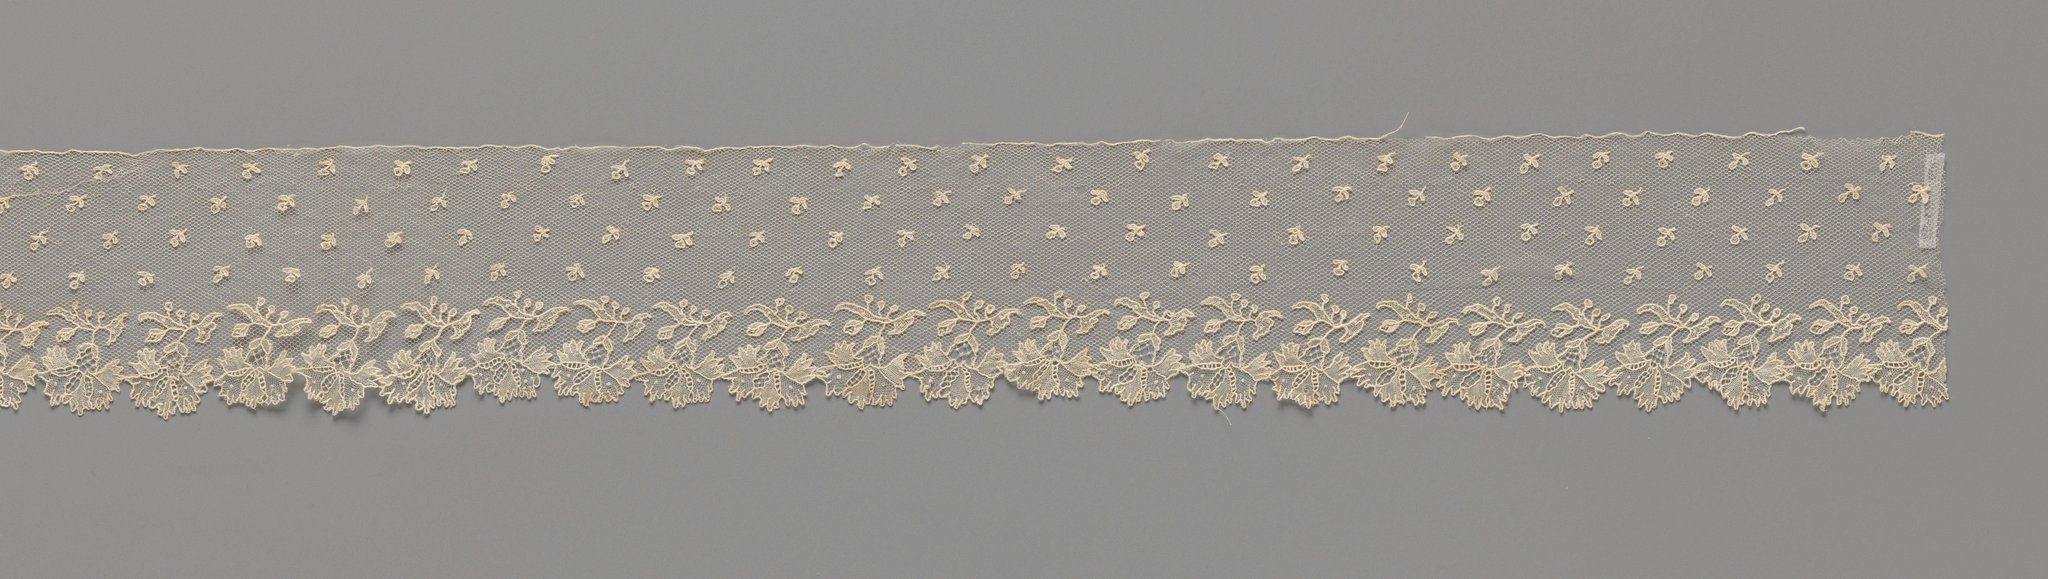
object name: strip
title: Strook applicatiekant met schulpenrand van hangende anjers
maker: Anonymous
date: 1820-1830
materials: linen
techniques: lace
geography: brussels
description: Strook naturelkleurige Brusselse applicatiekant: naaldkant geappliceerd op drochelgrond (kloskant). Strooipatroon met vier rijen ronde bloempjes aan een steeltje met twee blaadjes, waaronder een zich herhalend patroon langs de onderrand met hangende anjers. De bovenzijde van de strook is recht afgewerkt. De schulpenrand komt voort uit het patroon met de anjers.